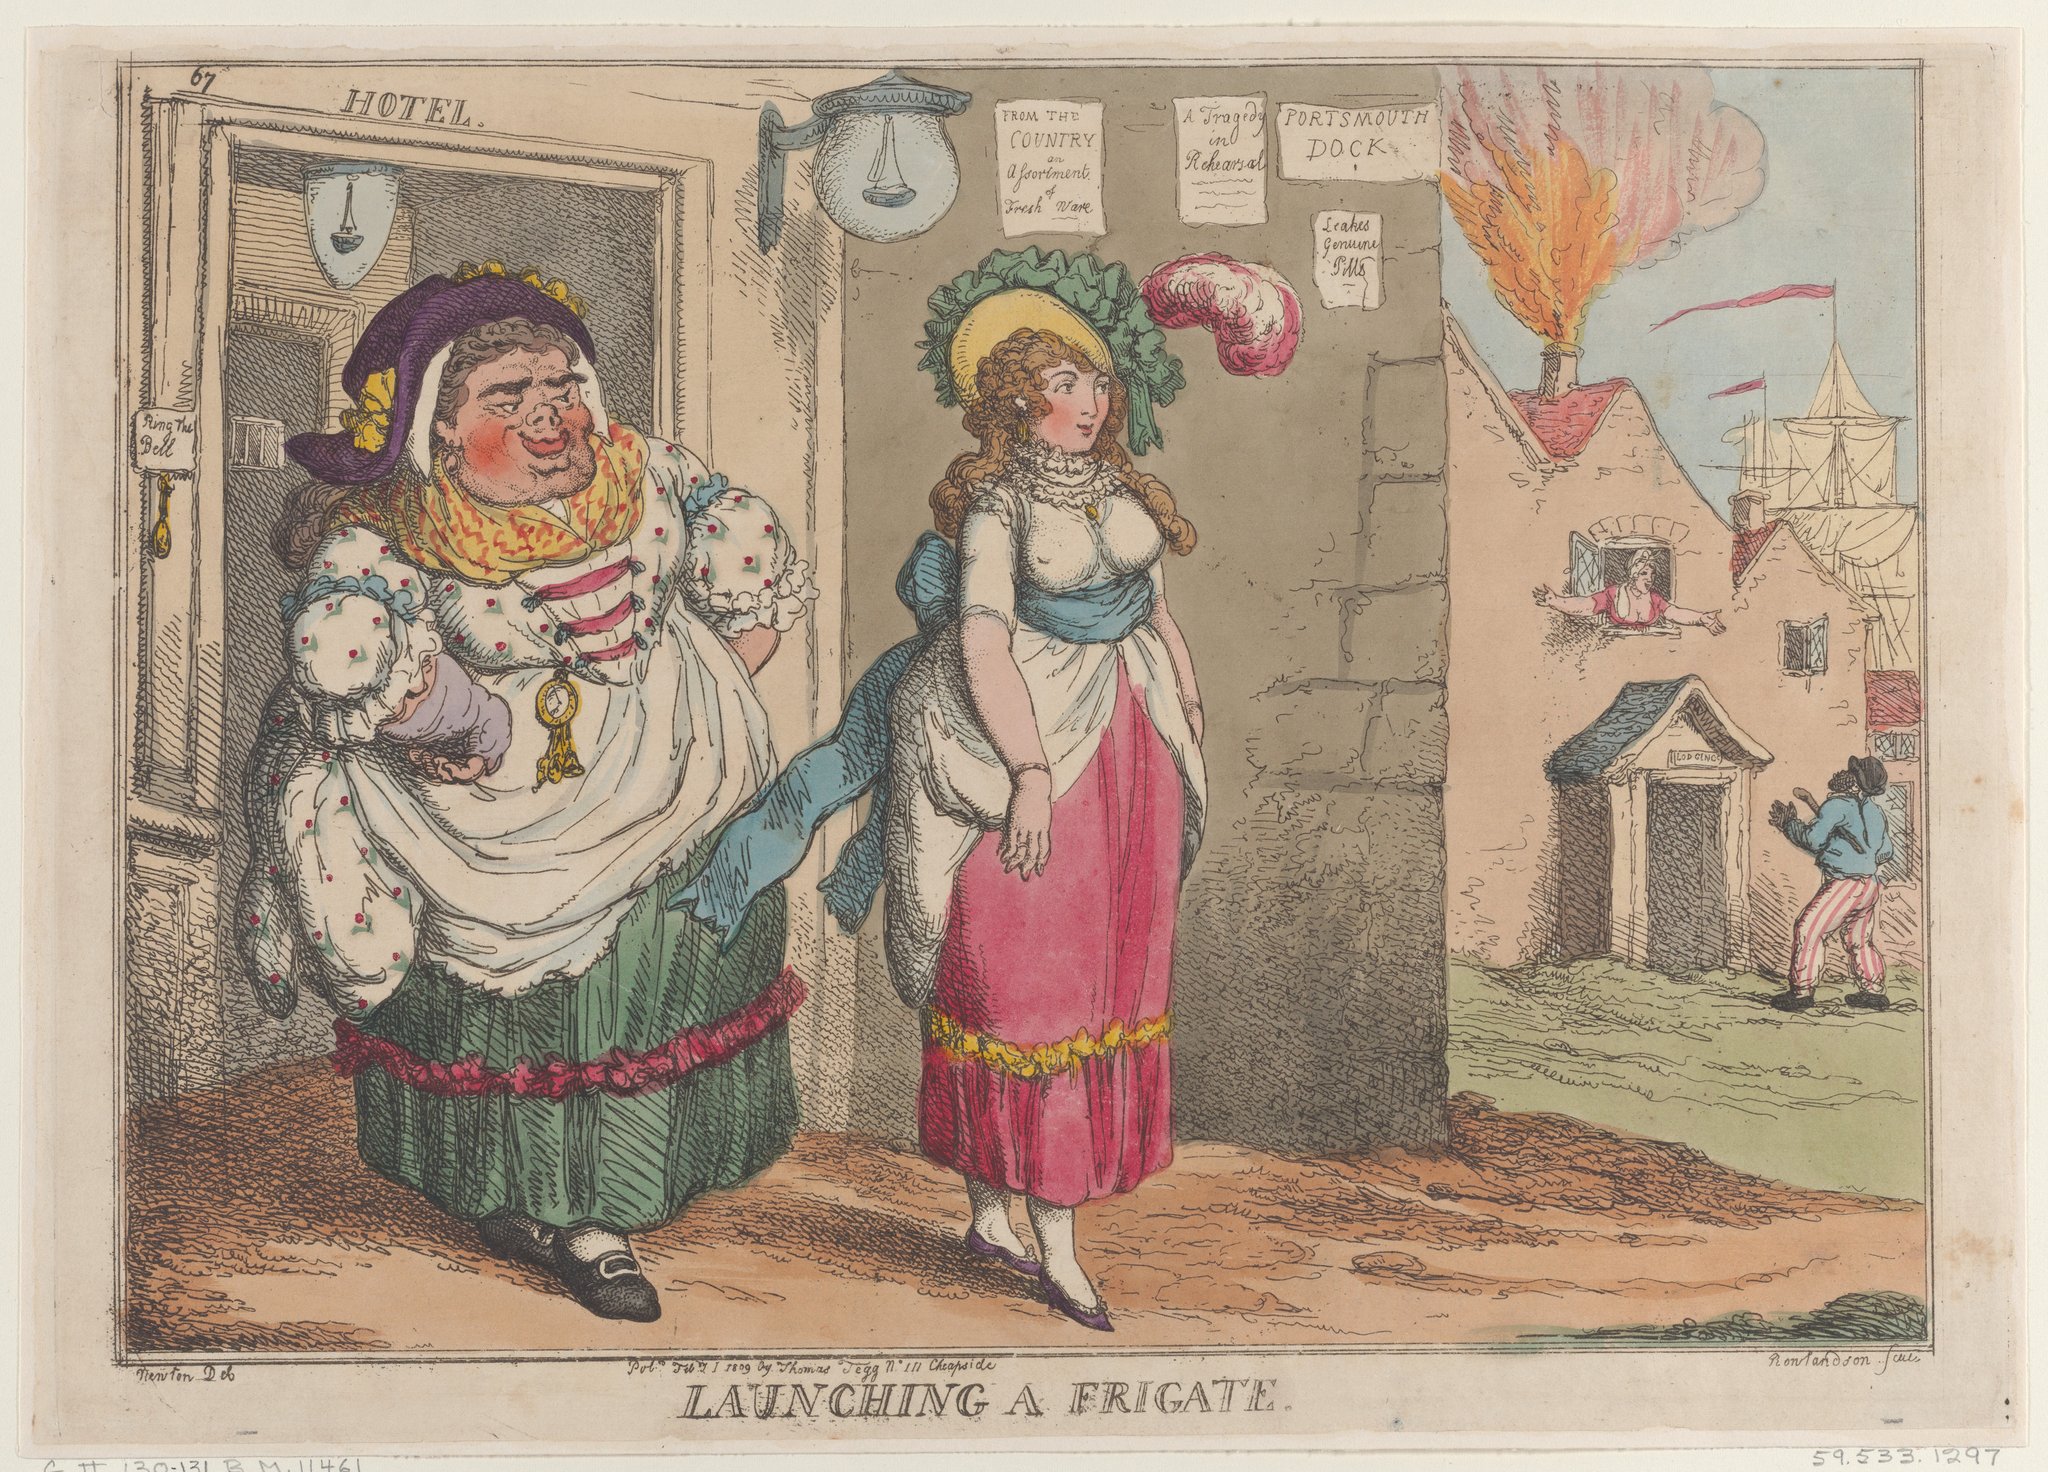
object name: print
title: Launching a Frigate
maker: thomas rowlandson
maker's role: artist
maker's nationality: british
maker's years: 1757-1827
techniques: etching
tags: satire,women,prostitutes